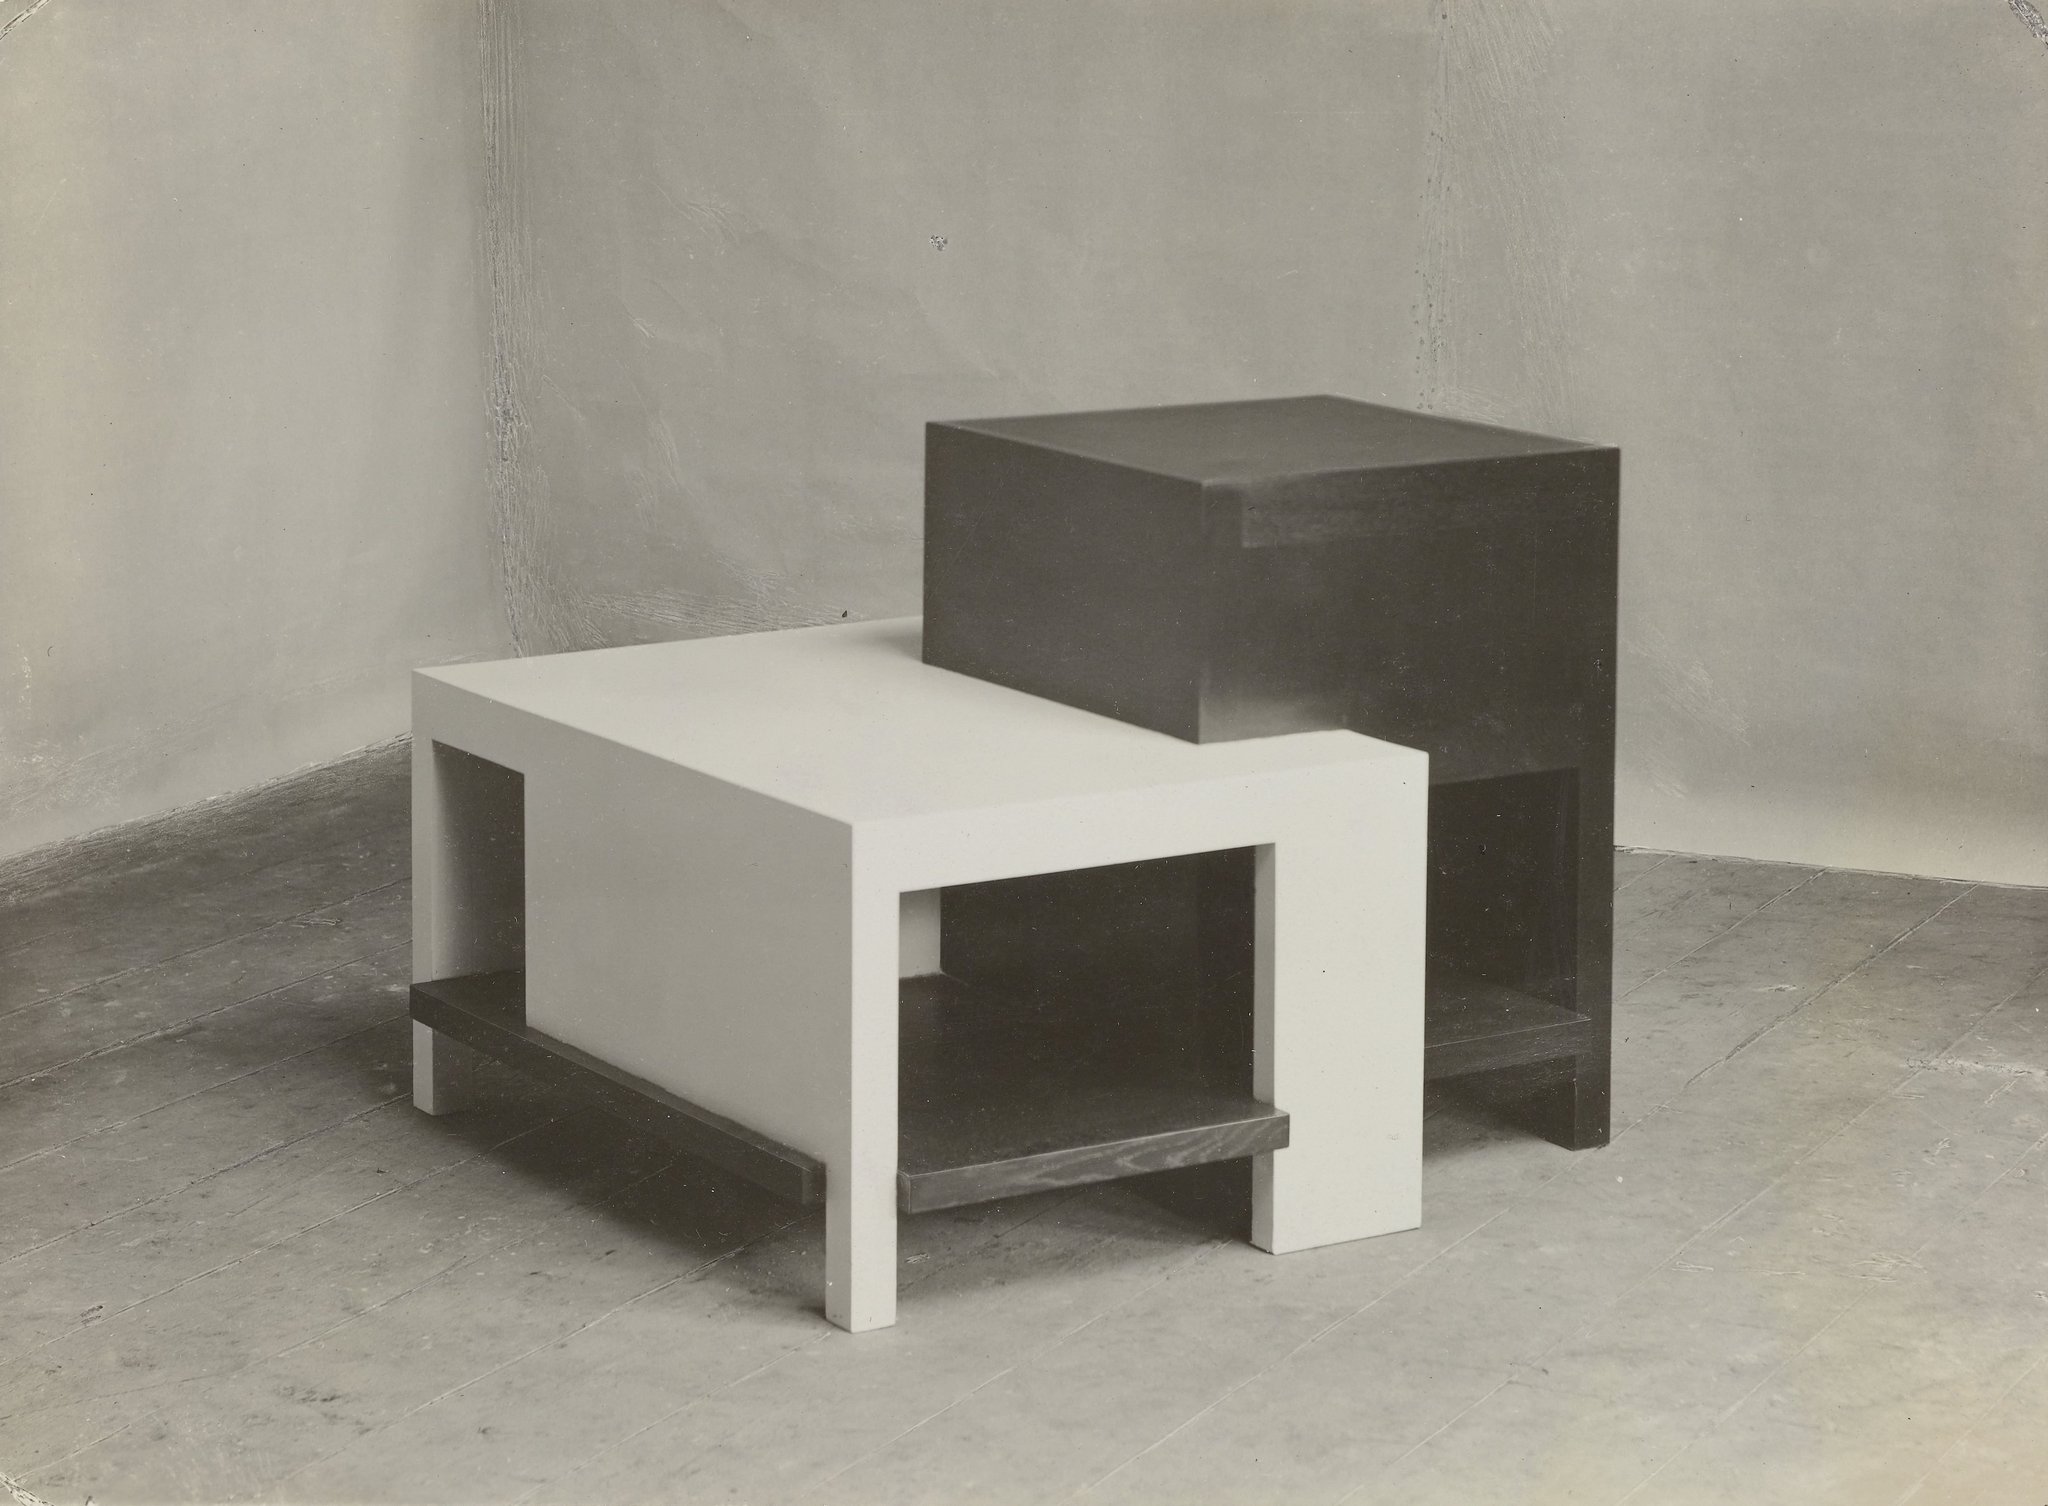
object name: photograph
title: Door Siebold van Ravesteyn ontworpen tafel voor het huis van M.R. Radermacher Schorer, Wilhelminapark 12, Utrecht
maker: Anonymous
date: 1924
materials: paper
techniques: gelatin silver print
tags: utrecht, table